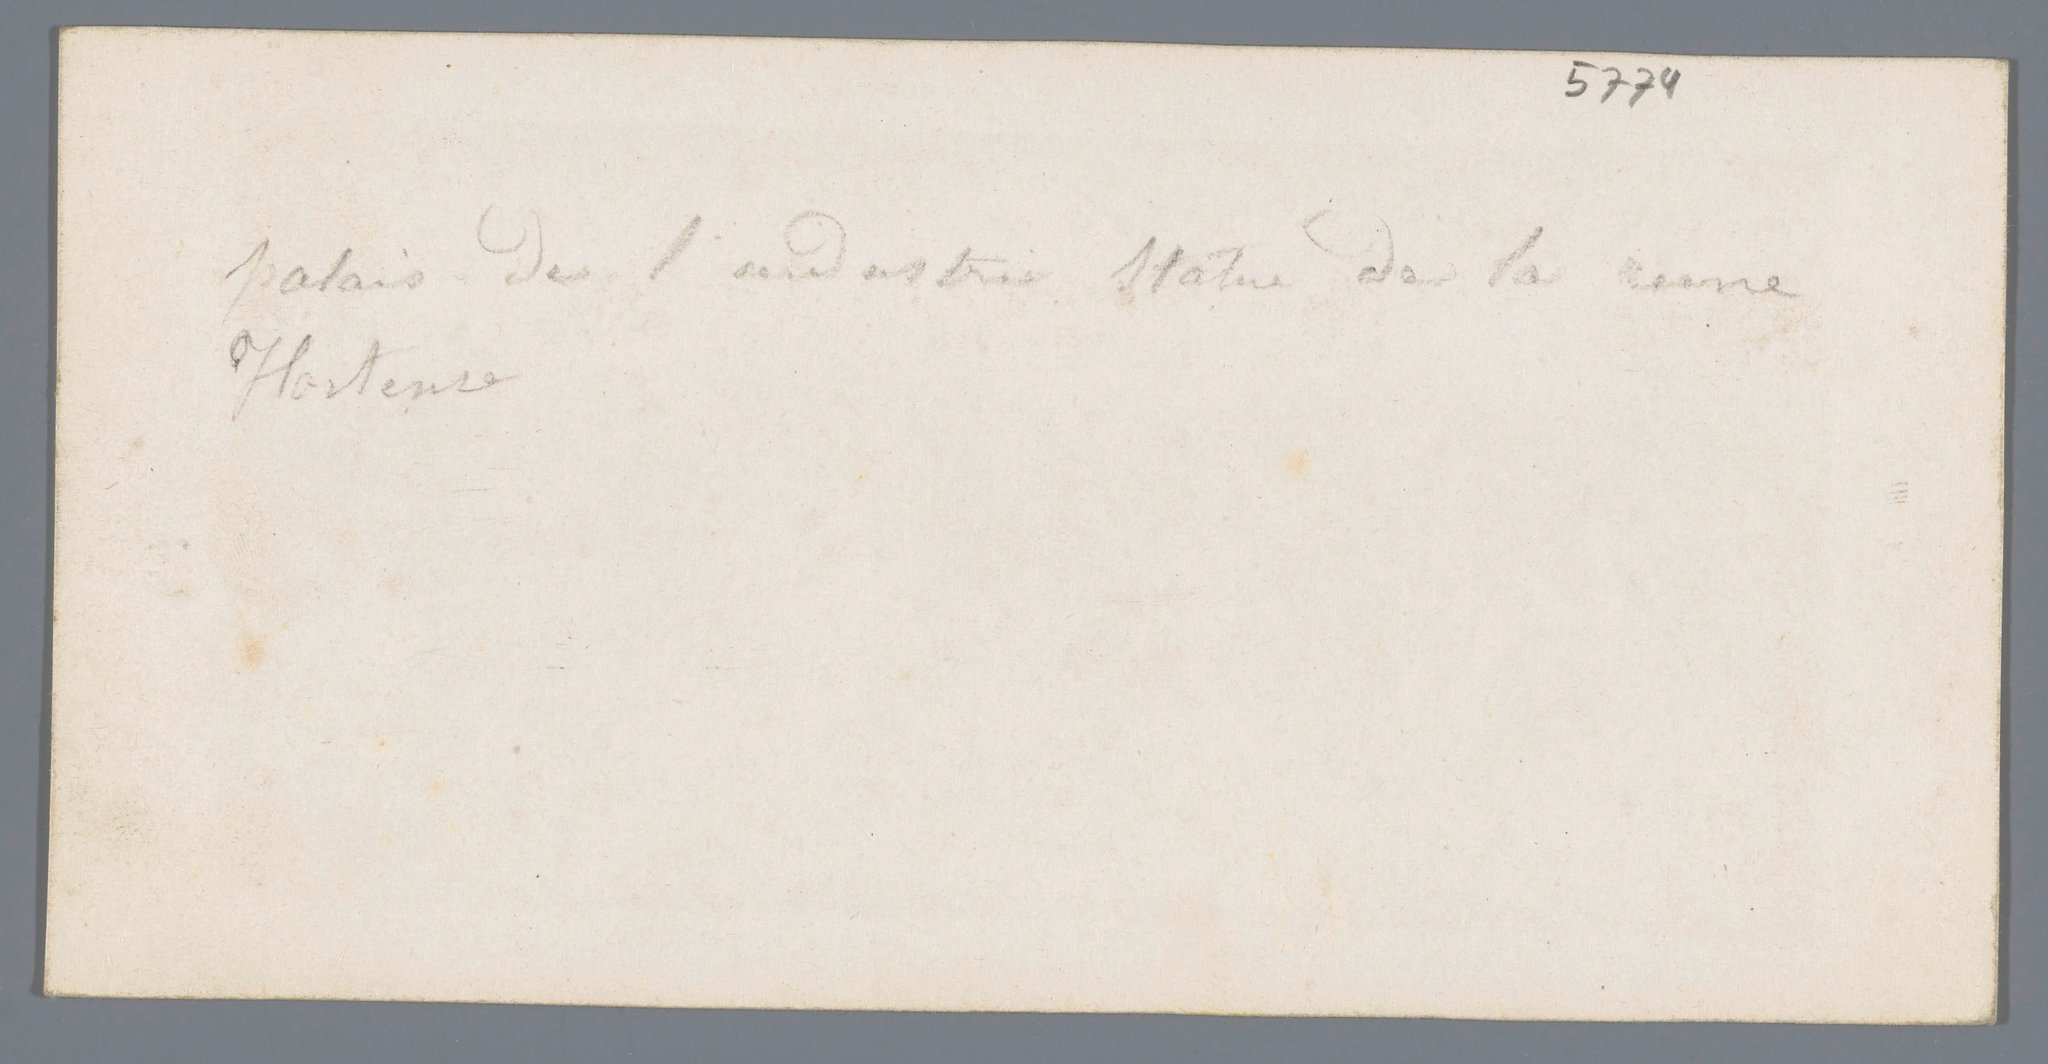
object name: stereograph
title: Sculptuur in het Palais de l'Industrie in Parijs, mogelijk tijdens de Exposition Universelle in 1855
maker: Anonymous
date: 1855-1880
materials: cardboard, photographic support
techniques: albumen print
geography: paris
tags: world fair, world exhibition, piece of sculpture, reproduction of a piece of sculpture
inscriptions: inscription: ‘Palais de l'Industrie, Statue de la reine Hortense’